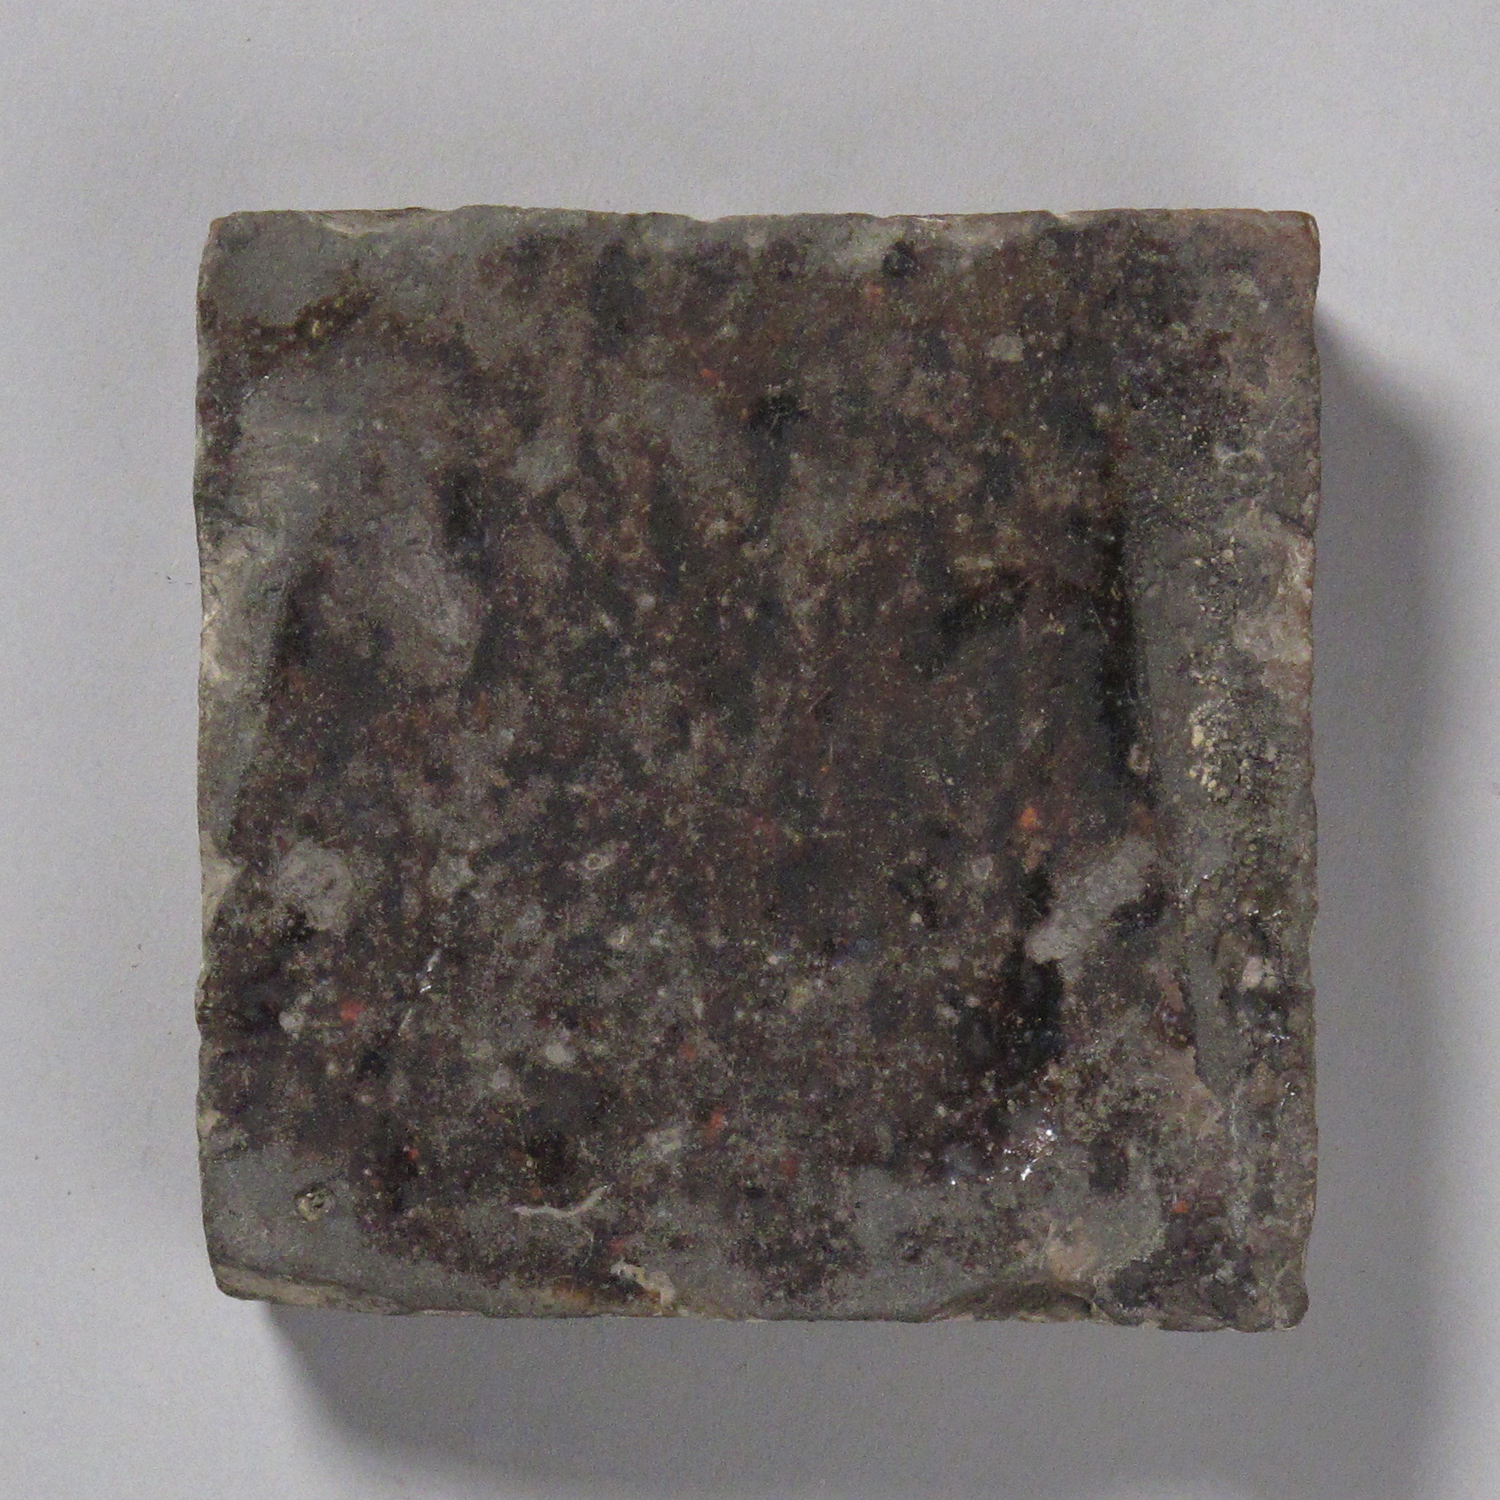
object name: tile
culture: french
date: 1201-1400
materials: earthenware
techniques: glazing